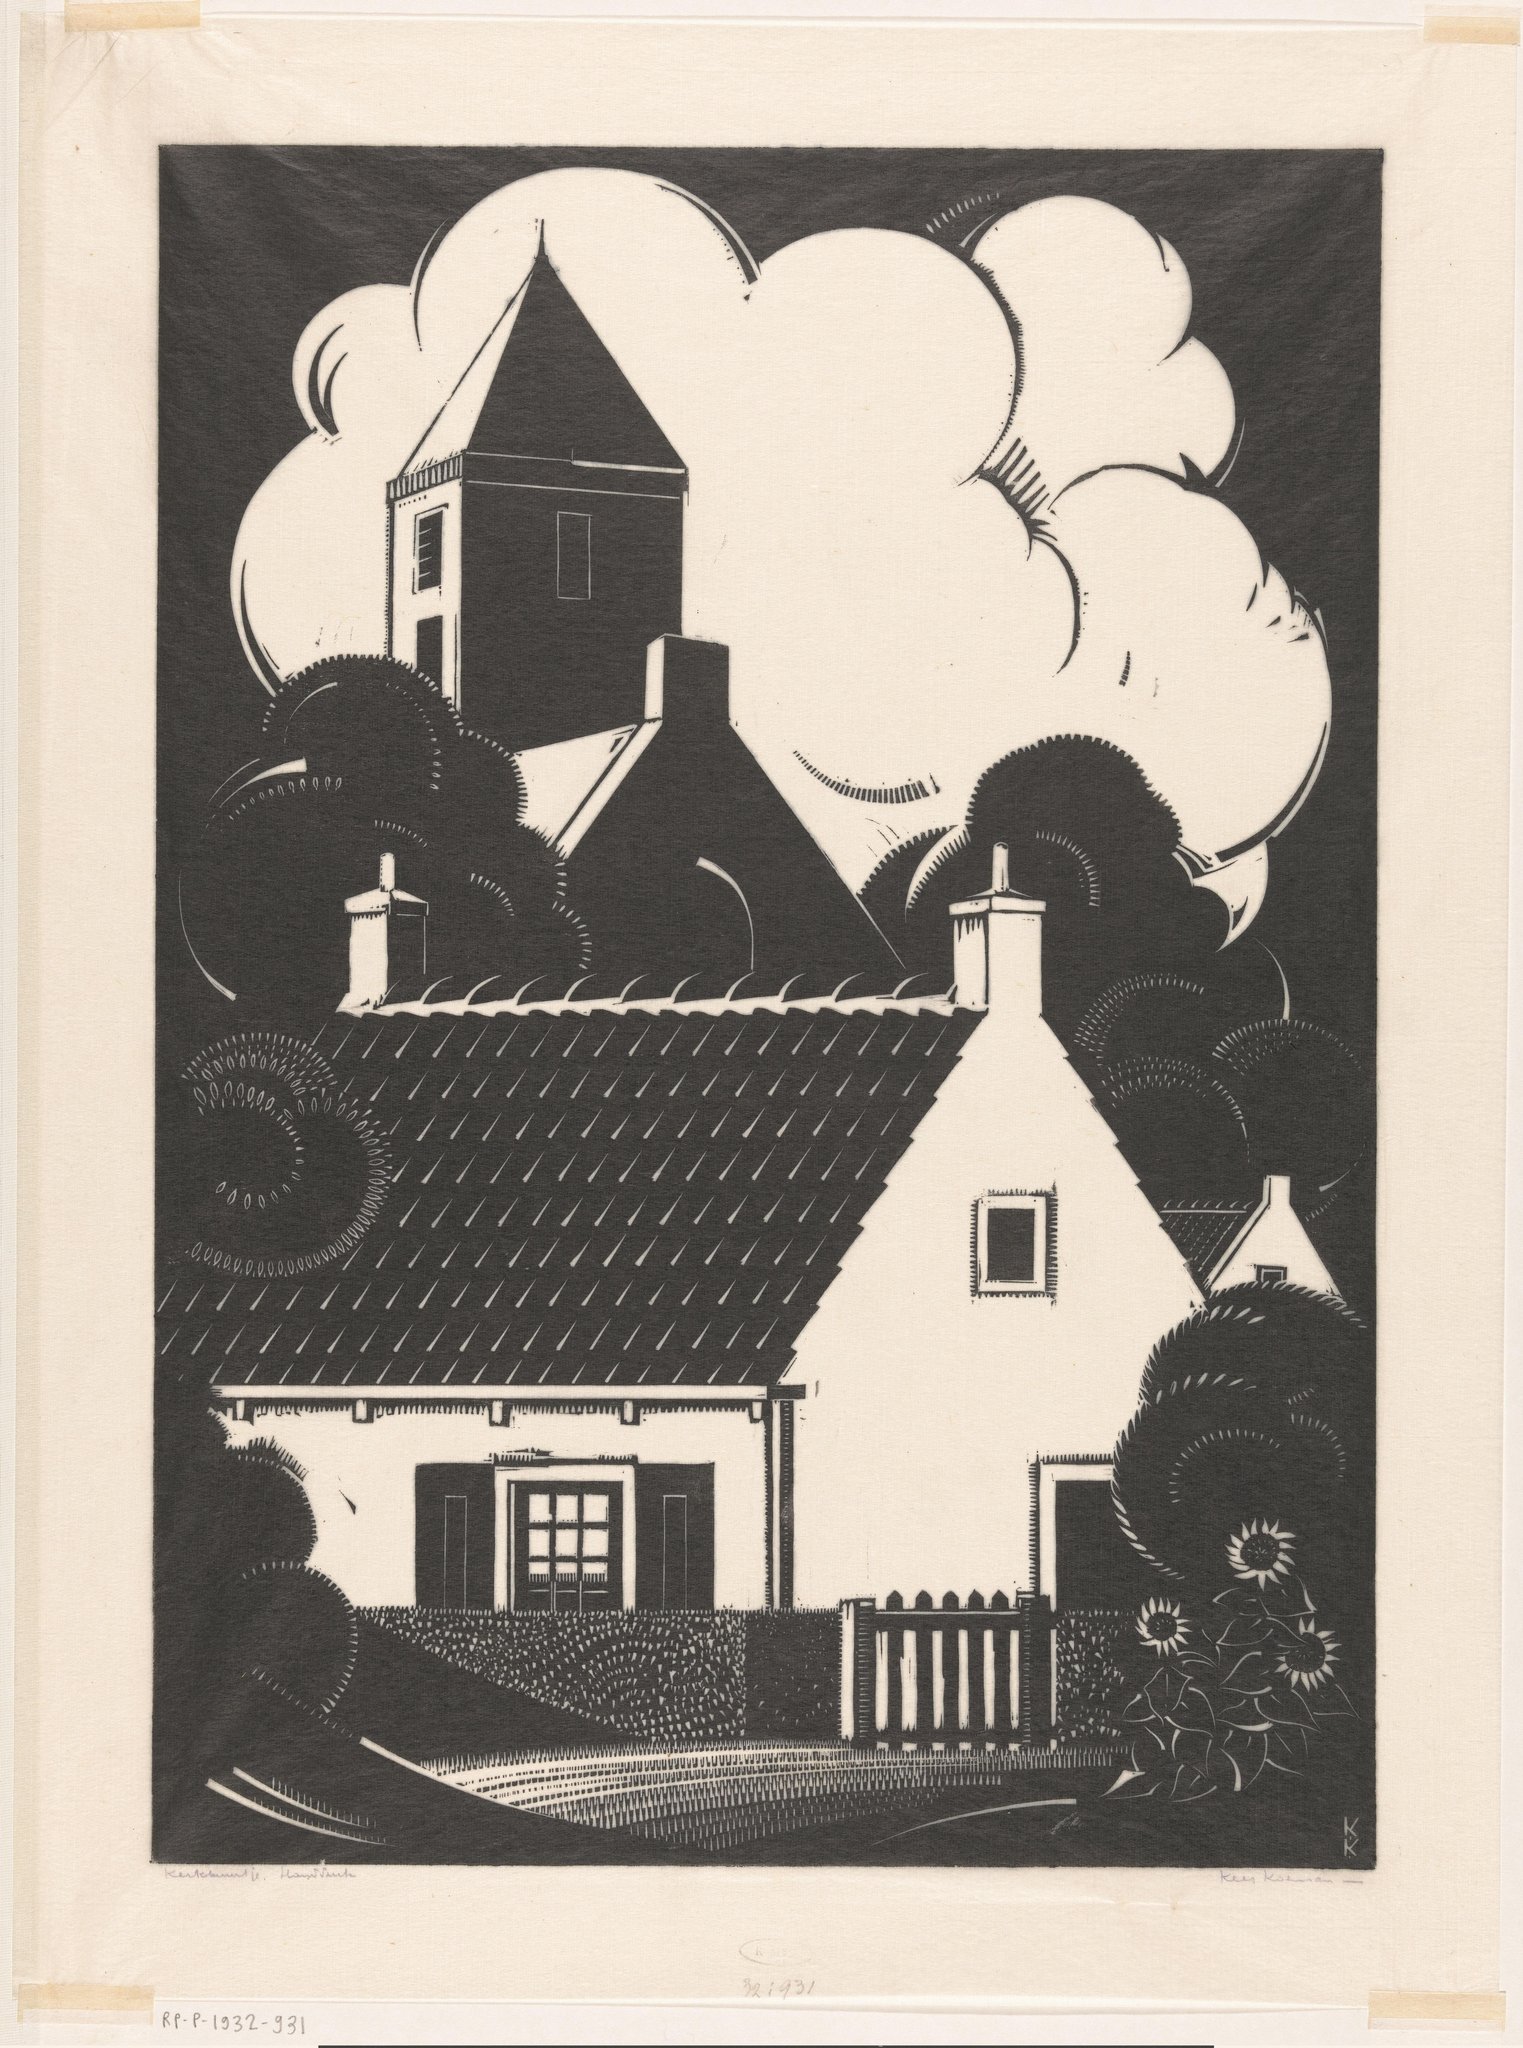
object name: print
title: Kerkbuurtje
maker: kees koeman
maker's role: print maker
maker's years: 1895-1954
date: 1905-1932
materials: paper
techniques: woodcut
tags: clouds, village, church (exterior)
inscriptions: collector's mark: Lugt 2228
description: Huizen en bomen voor een kerk. Achter de kerk een wolk. Rechts op de voorgrond zonnebloemen.